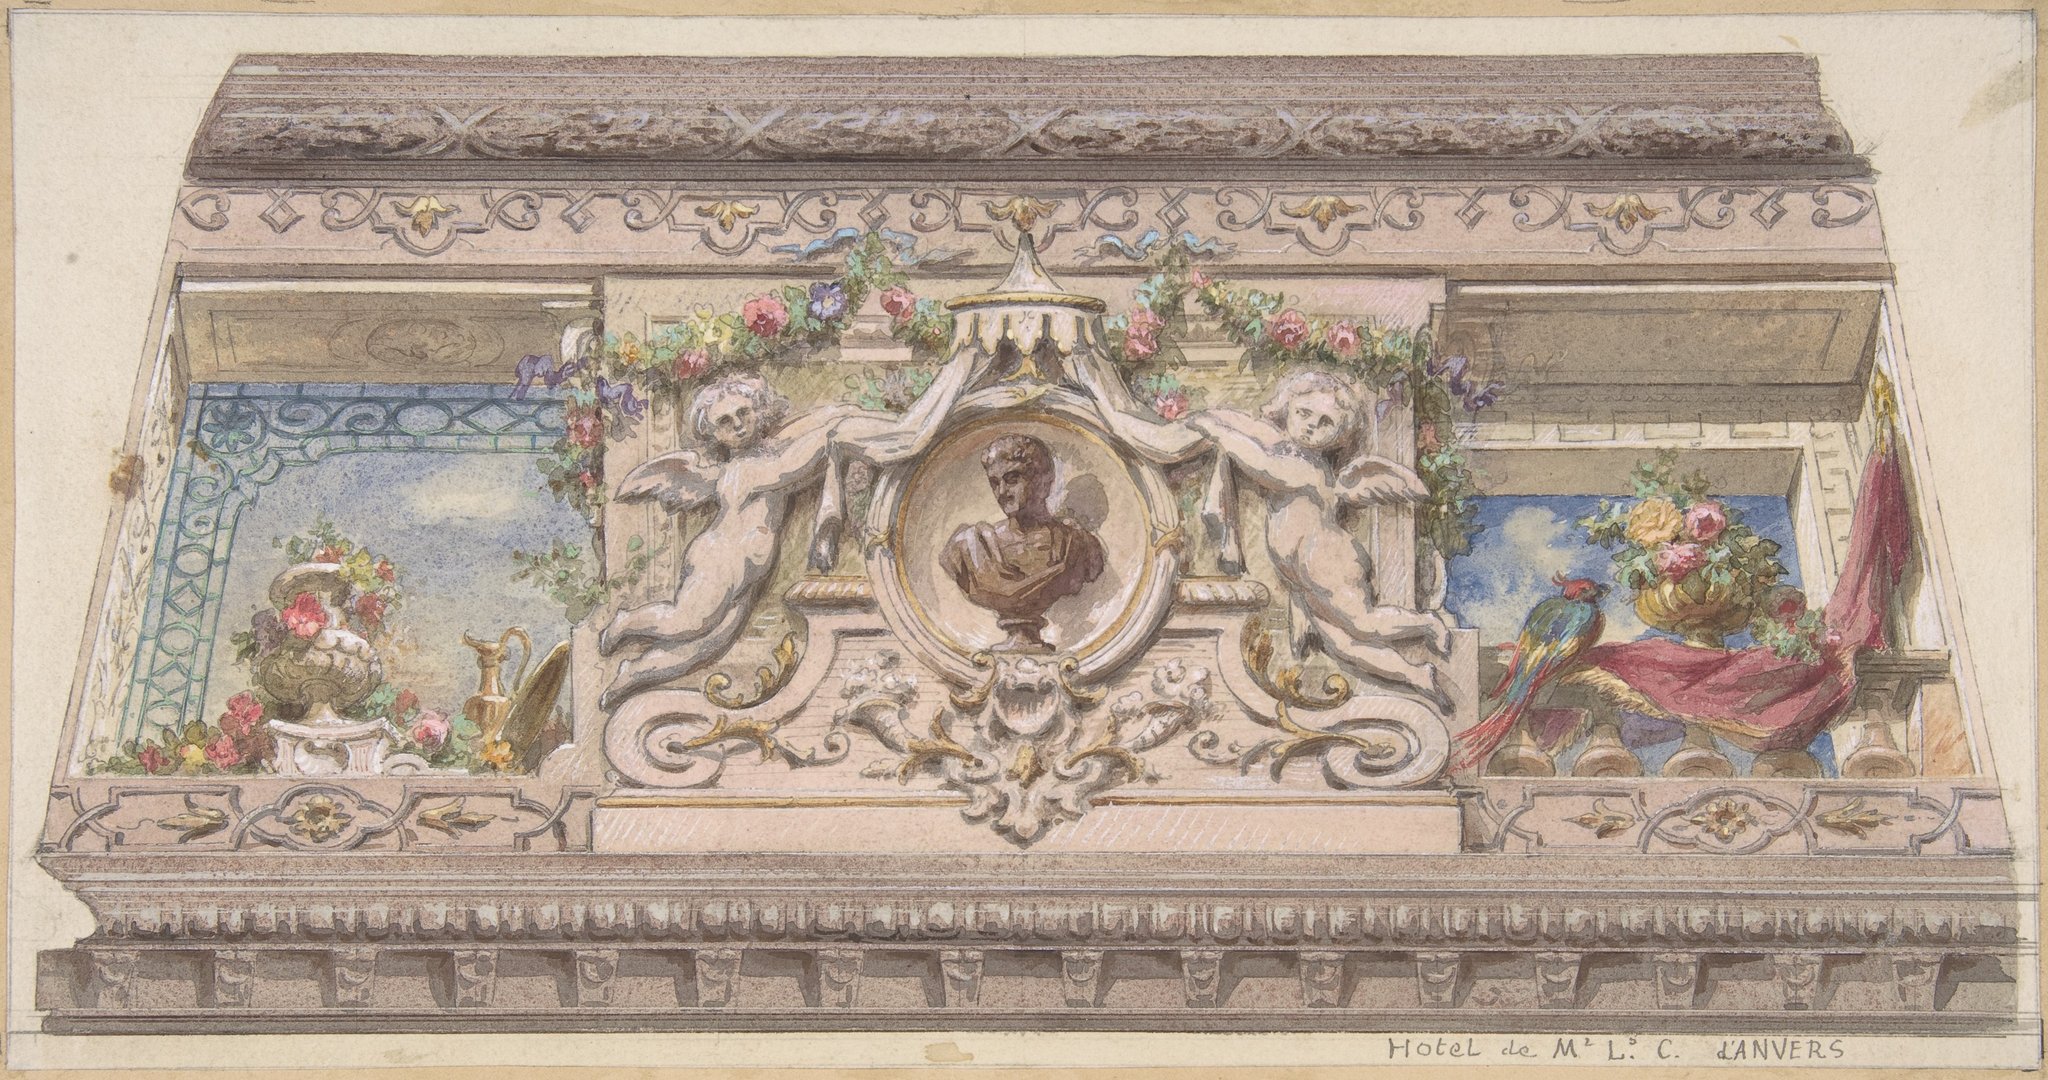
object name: drawing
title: Design for Cove, Hôtel Cahen d'Anvers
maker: jules-edmond-charles lachaise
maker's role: artist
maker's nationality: french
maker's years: 1897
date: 1851-1900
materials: ink, watercolor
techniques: pen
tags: birds,putti,flowers